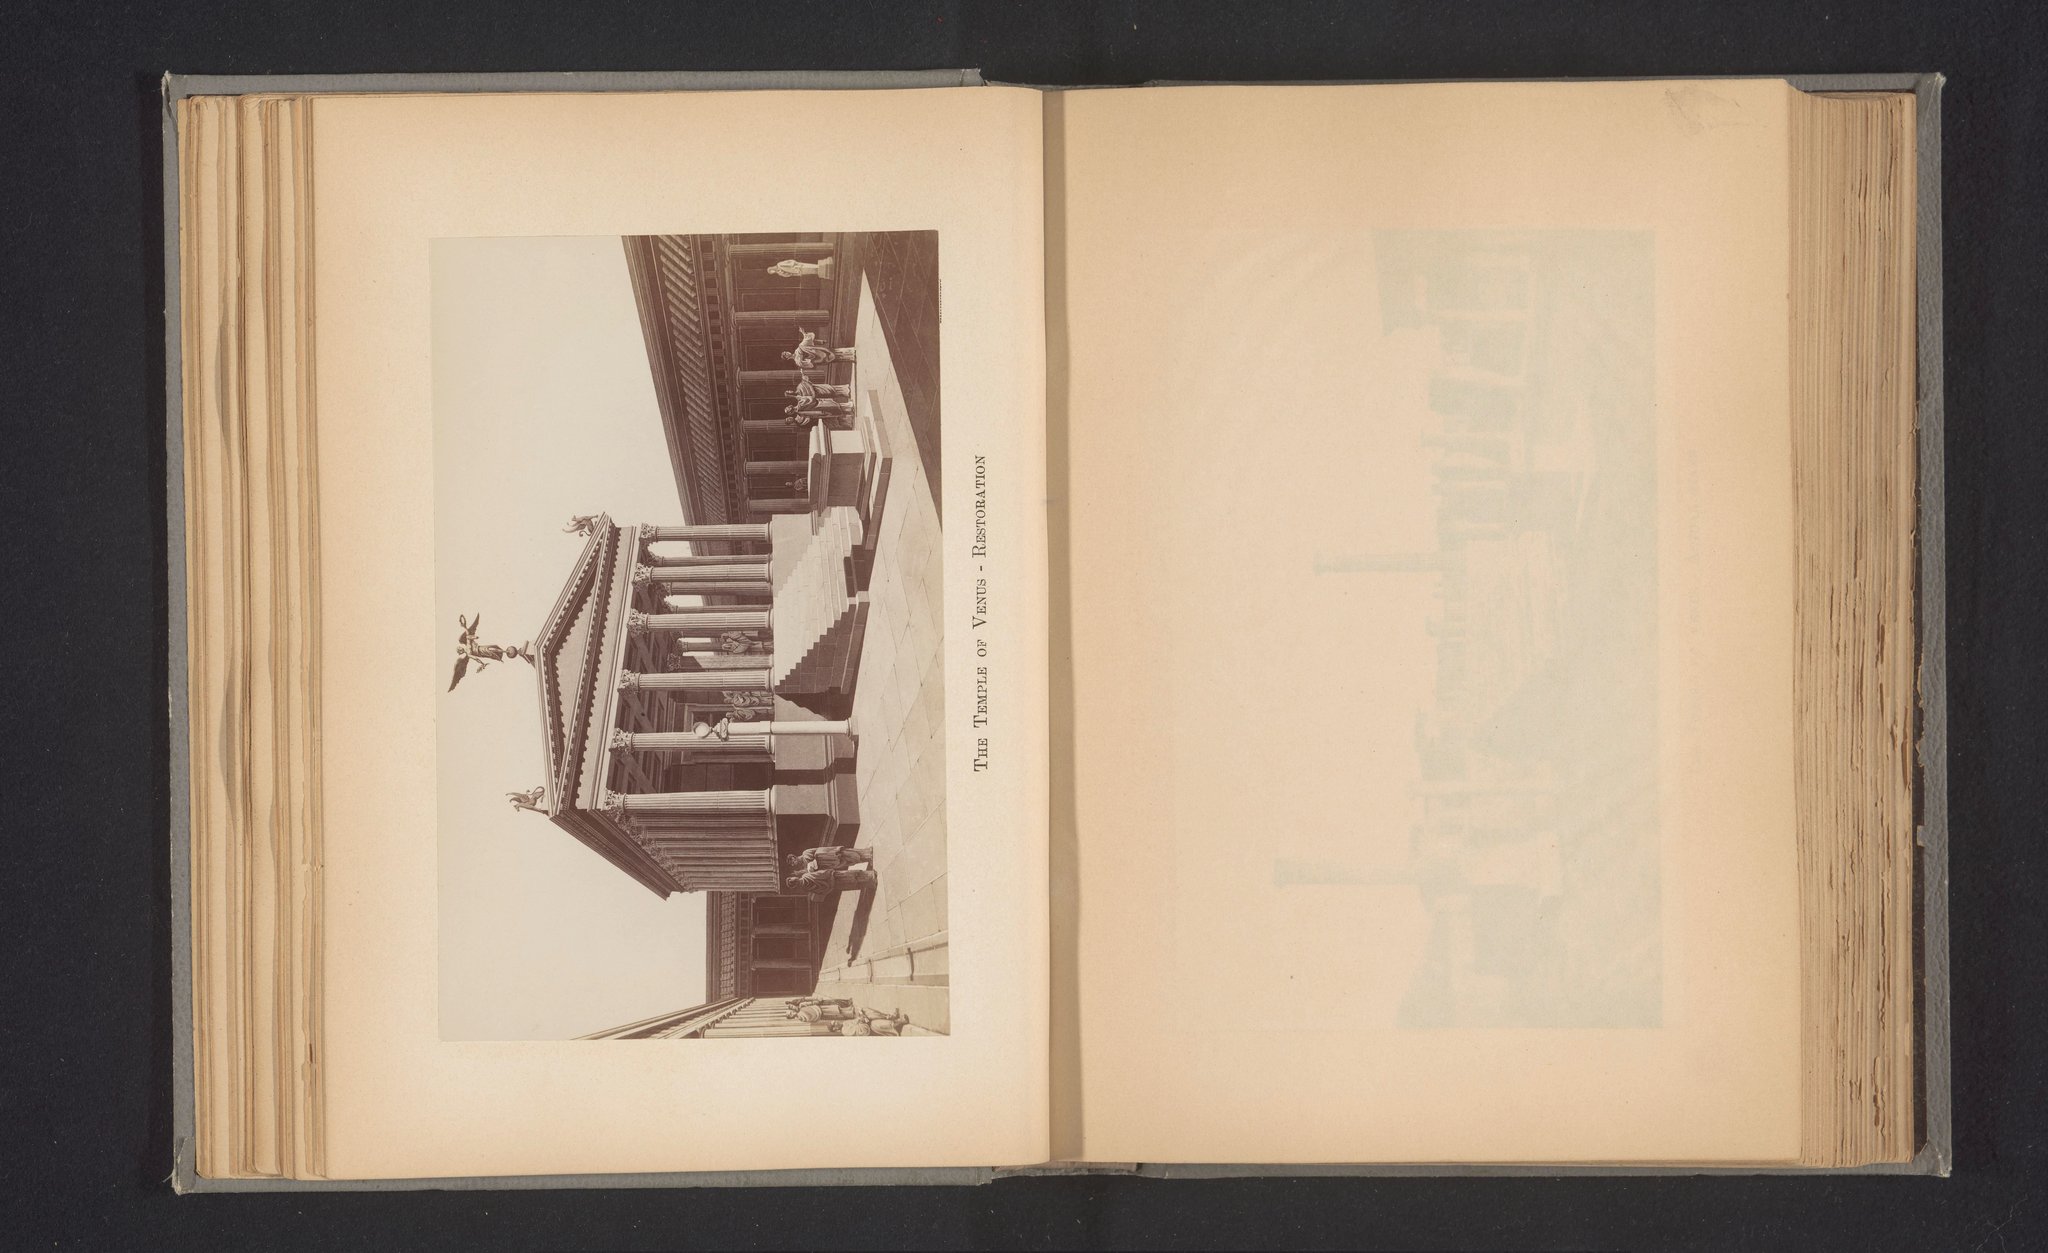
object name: page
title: Fotoreproductie van een gezicht op de tempel van Venus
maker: Anonymous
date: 1890-1895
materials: photographic support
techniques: albumen print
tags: column, pillar ~ architecture, temple, shrine ~ roman religion